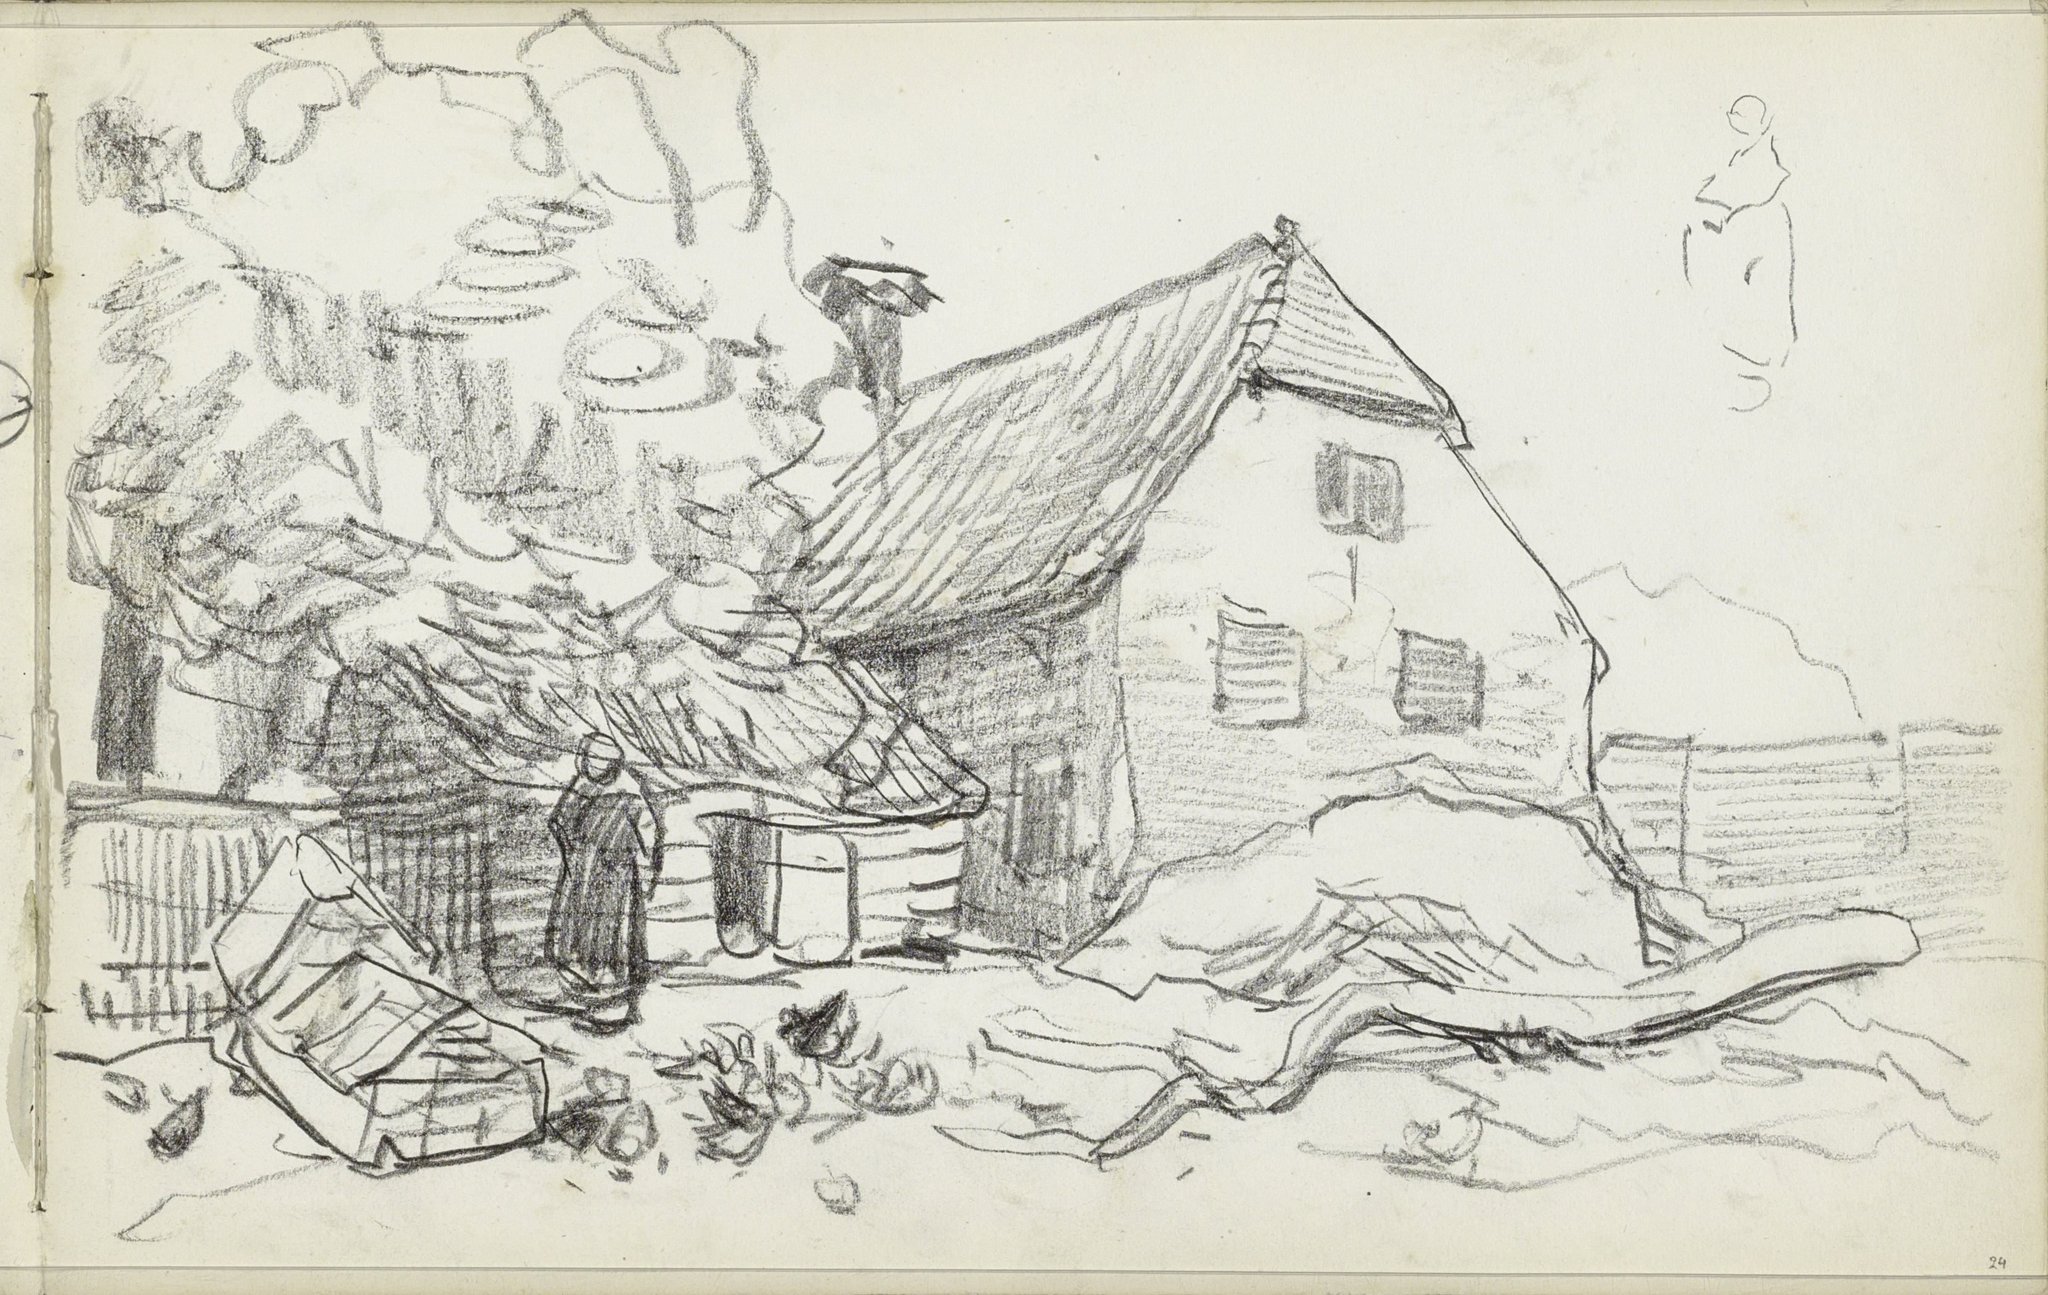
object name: sketchbook leaf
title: Figuur op een erf voor een huis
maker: johannes bosboom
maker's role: draughtsman, painter, print maker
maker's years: 1817-1891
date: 1873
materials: chalk, paper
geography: scheveningen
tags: cottage, fowl (cock, hen, chicken, etc.)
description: Op het erf scharrelen kippen. Tevens een figuurstudie. Blad 24 recto uit een schetsboek met 39 bladen.